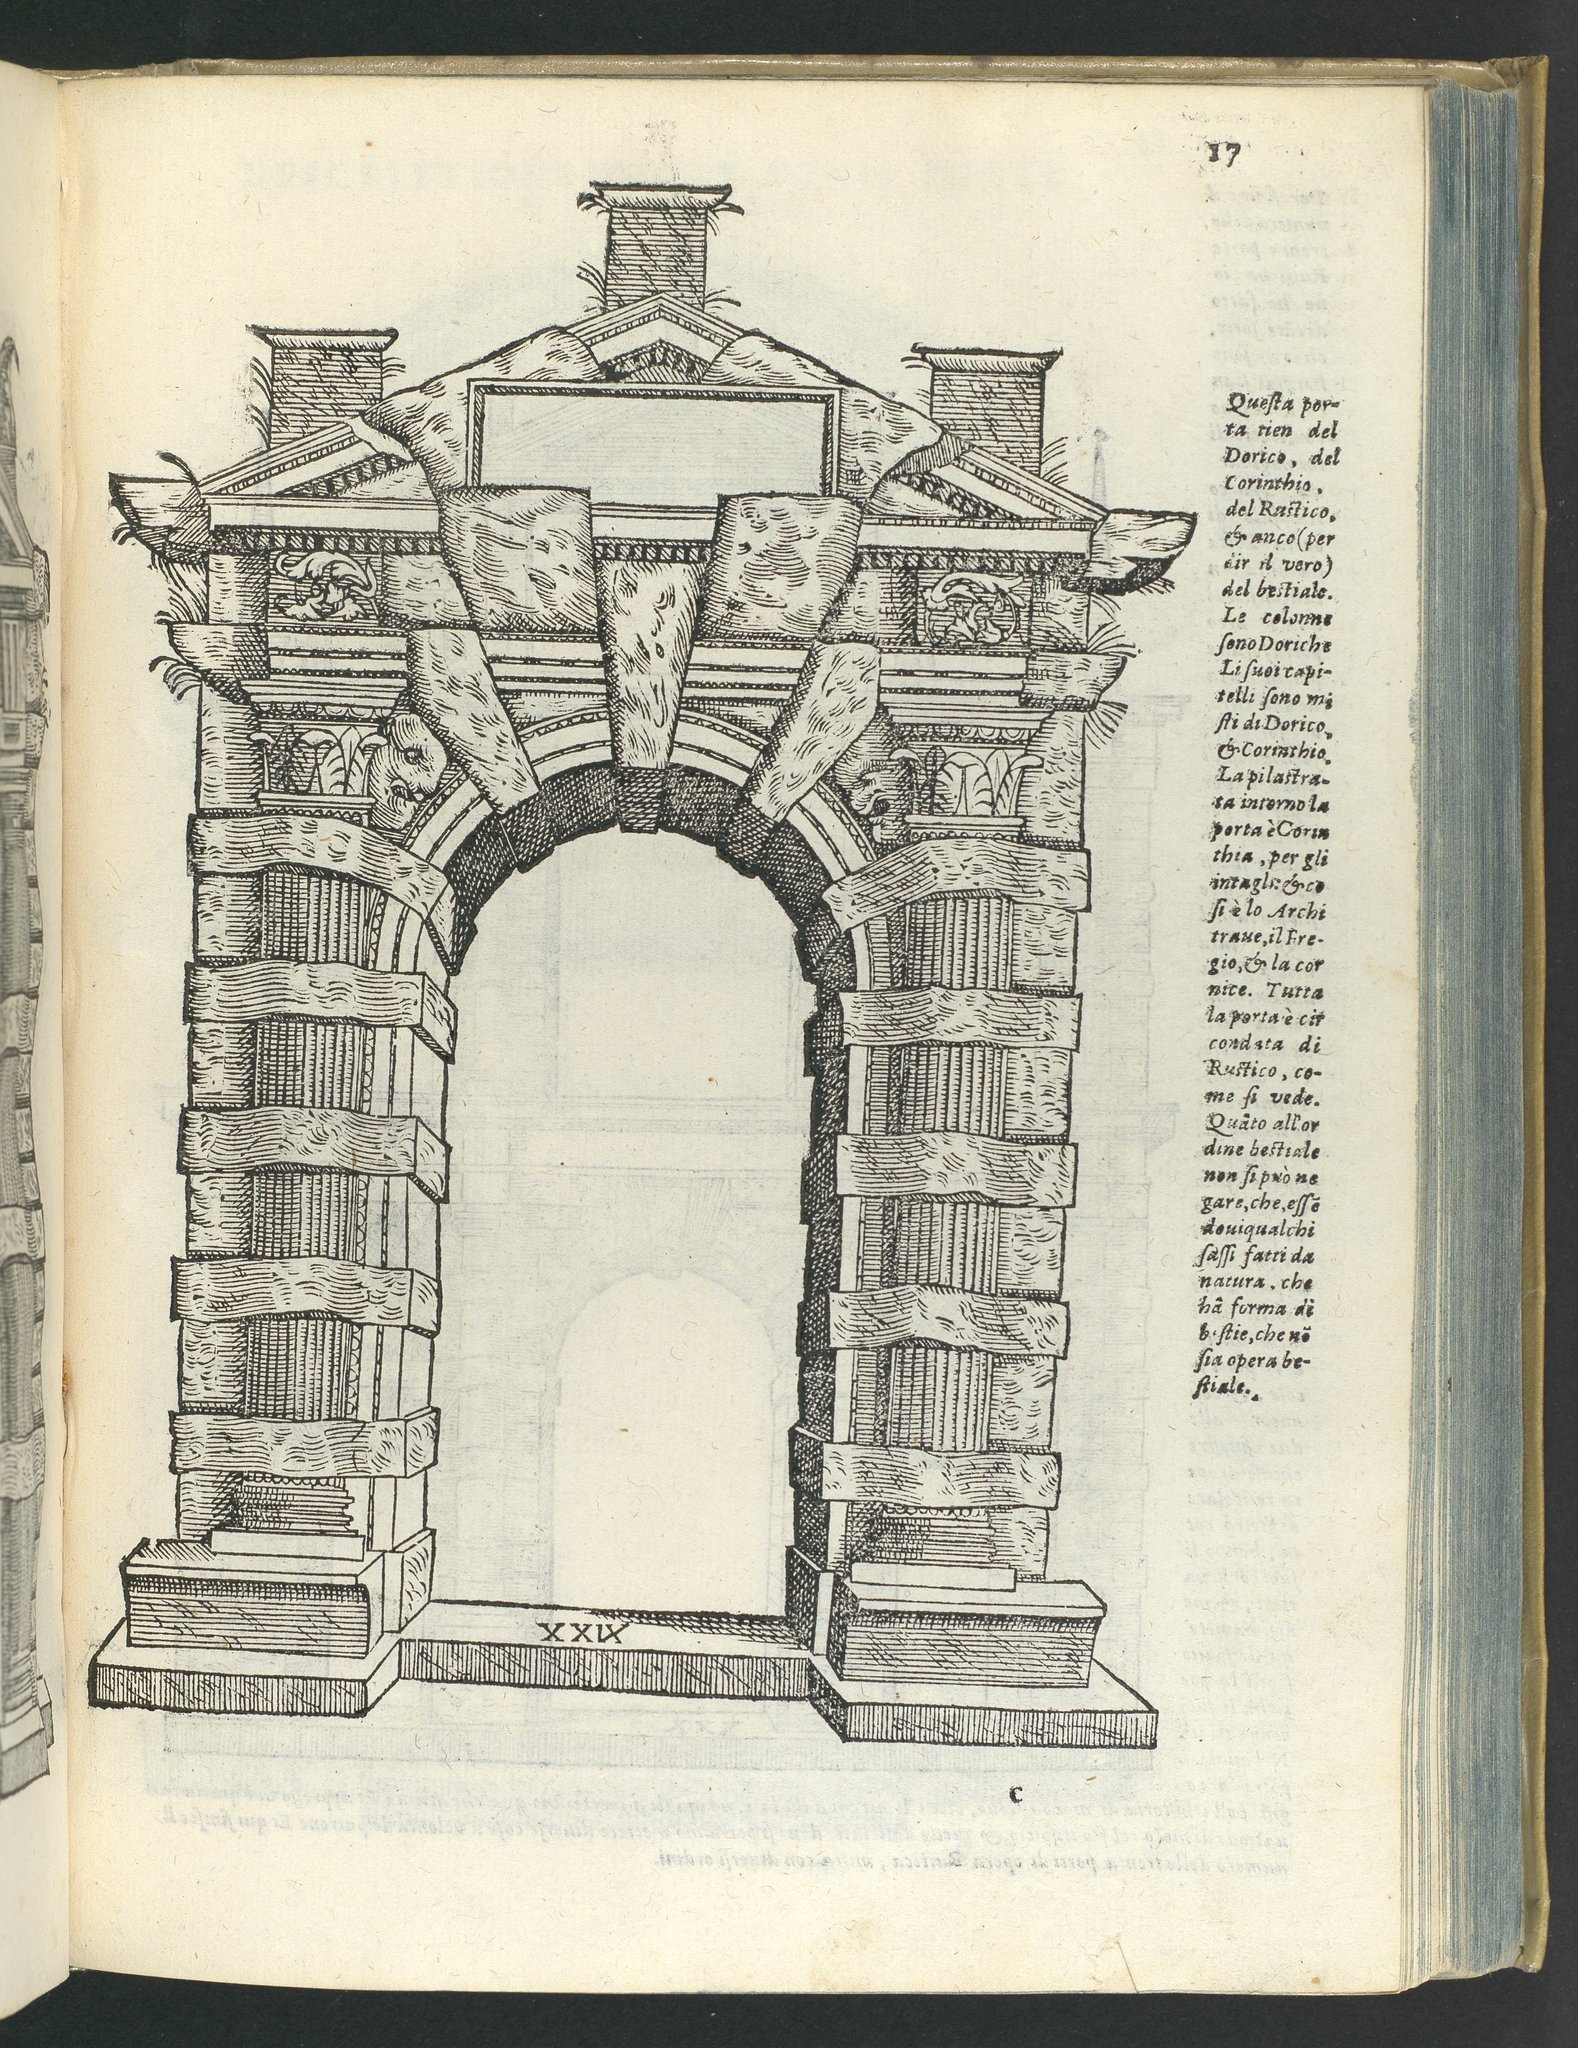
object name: book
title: Tutte l'opere d'architettura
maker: sebastiano serlio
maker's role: author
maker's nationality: italian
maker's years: 1475-1554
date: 1584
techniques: printing, woodcut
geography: italy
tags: architecture,arches